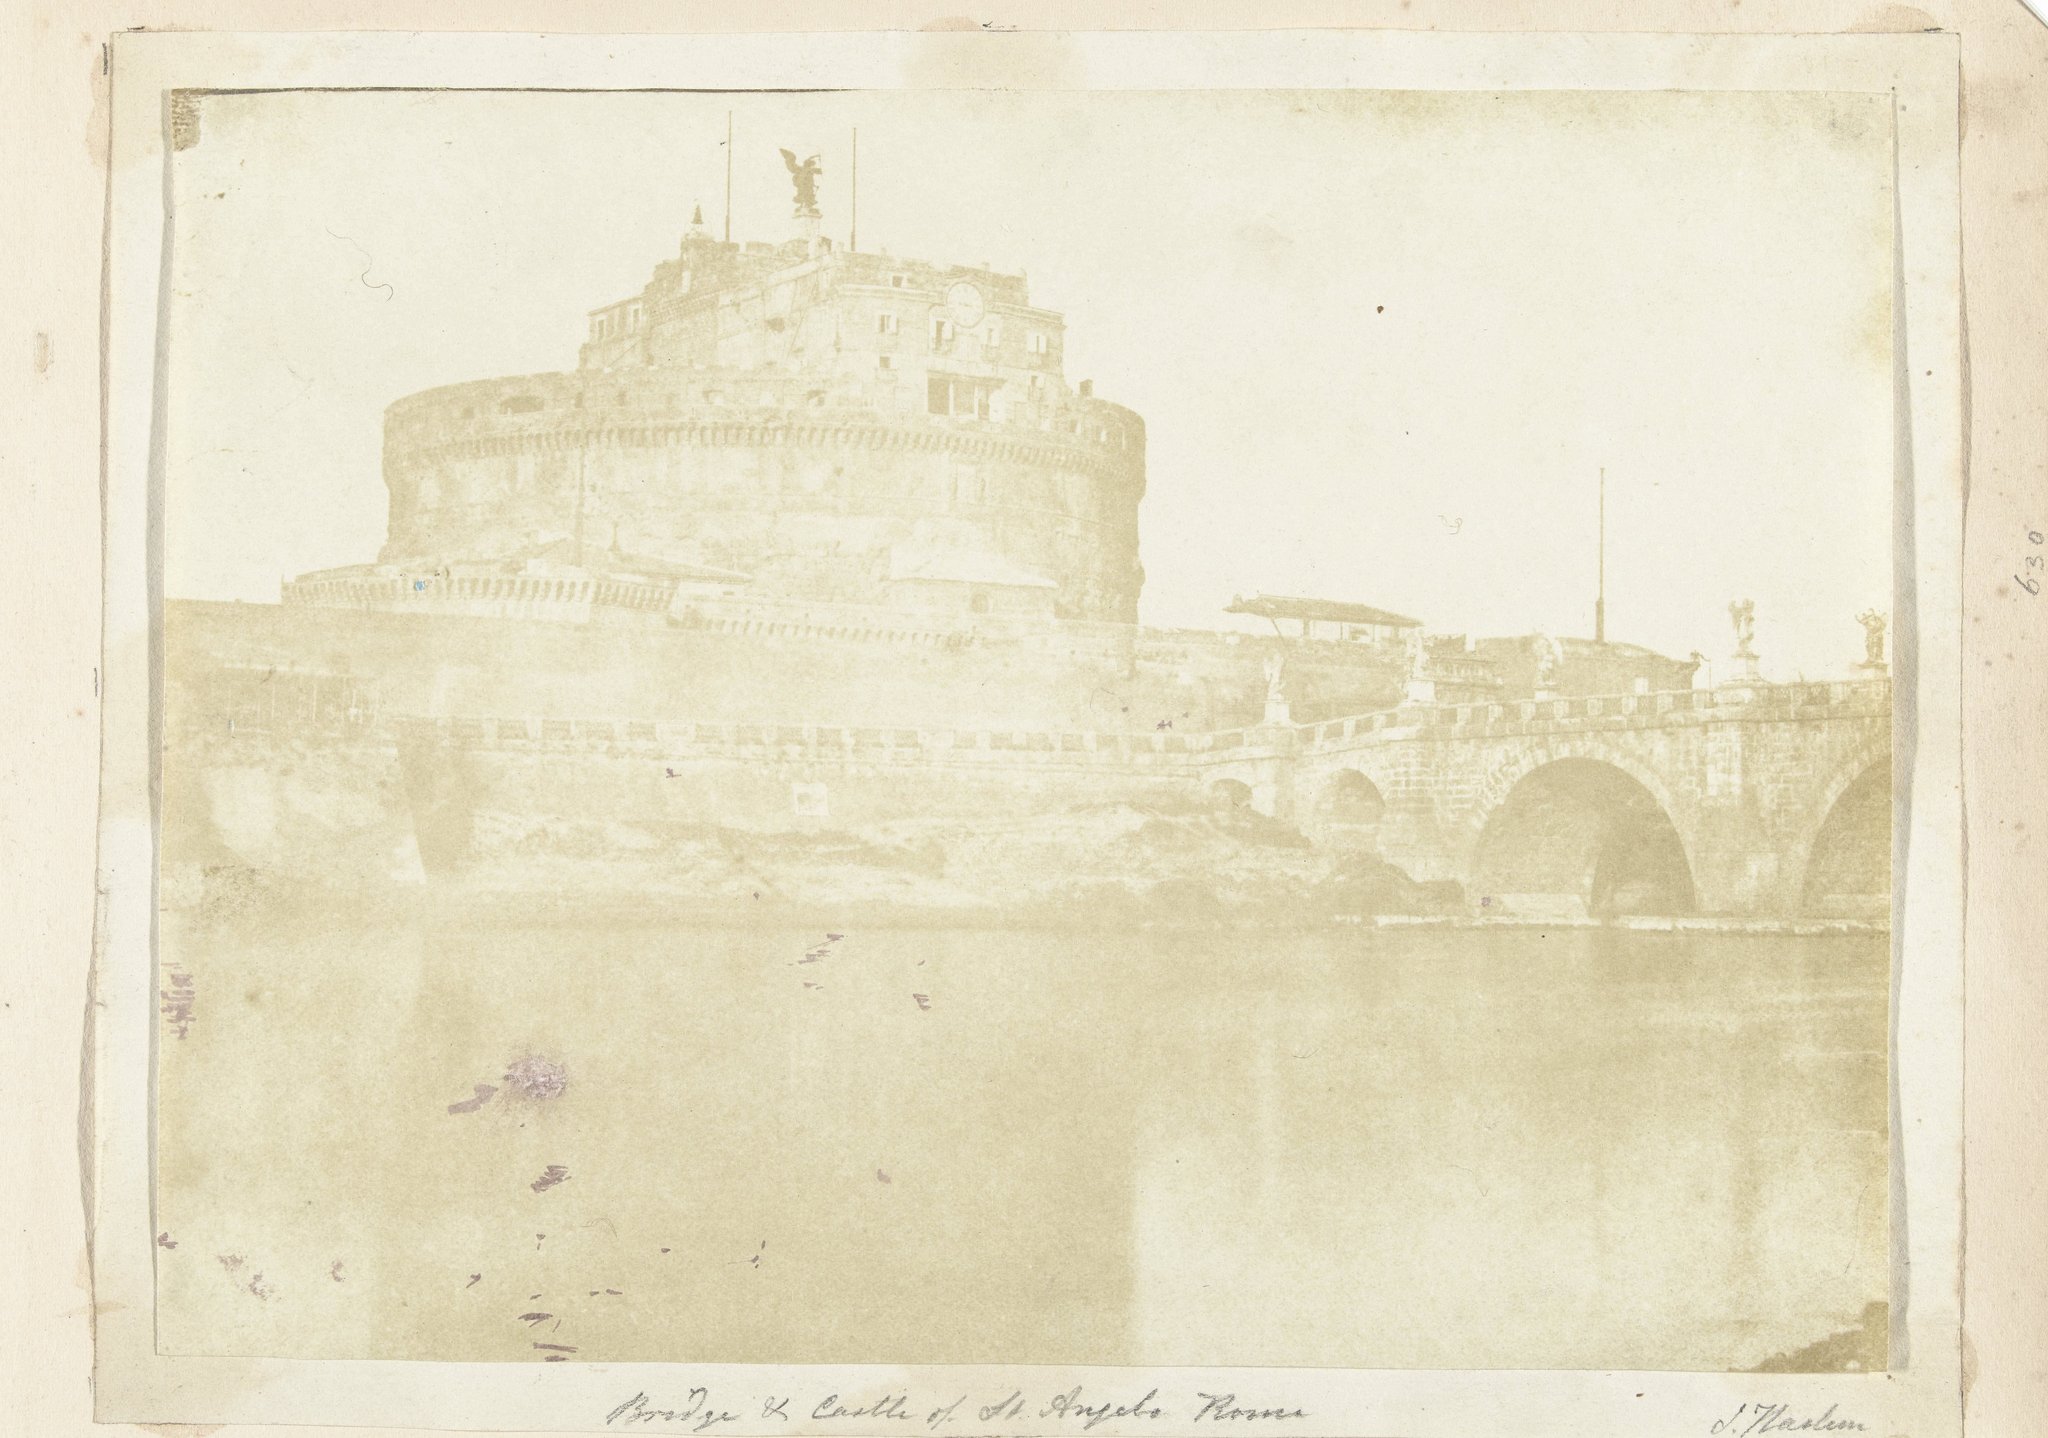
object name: photograph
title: Gezicht op de Engelenburcht in Rome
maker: j. martin (fotograaf)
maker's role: fotograaf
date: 1845-1855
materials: cardboard, photographic support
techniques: salted paper print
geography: great britain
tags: fortress